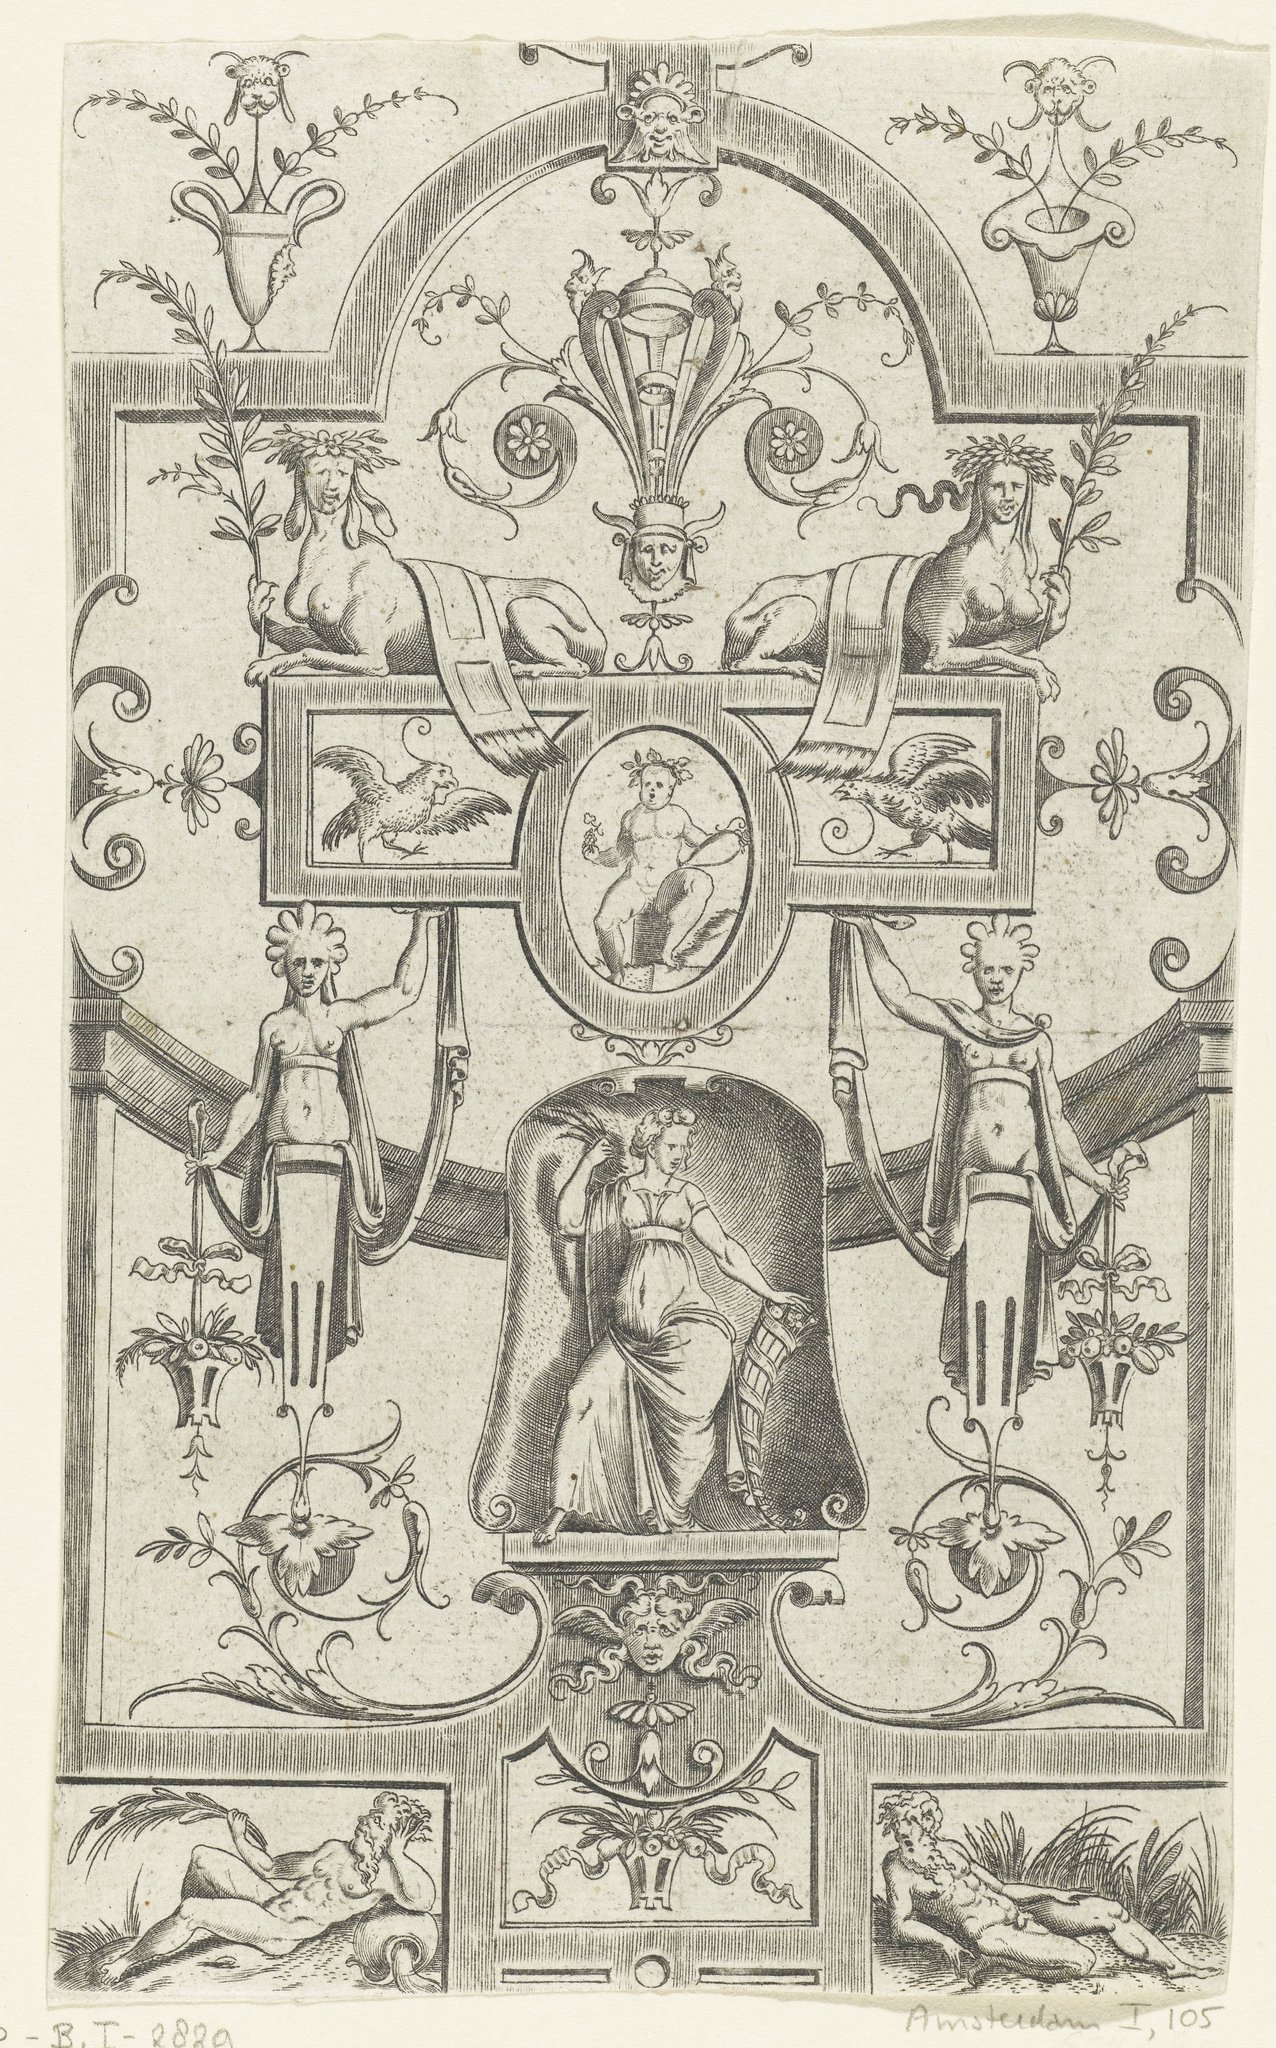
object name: ornament print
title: Vlakdecoratie met grotesken, in het midden staat Ceres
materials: paper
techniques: engraving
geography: netherlands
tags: (story of) ceres (demeter), (story of) bacchus (dionysus), liber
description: Ceres staat in een nis. Twee vrouwelijke hermen ter weerszijden van de nis houden een cartouche omhoog waarin Bacchus zit, geflankeerd door twee vogels.